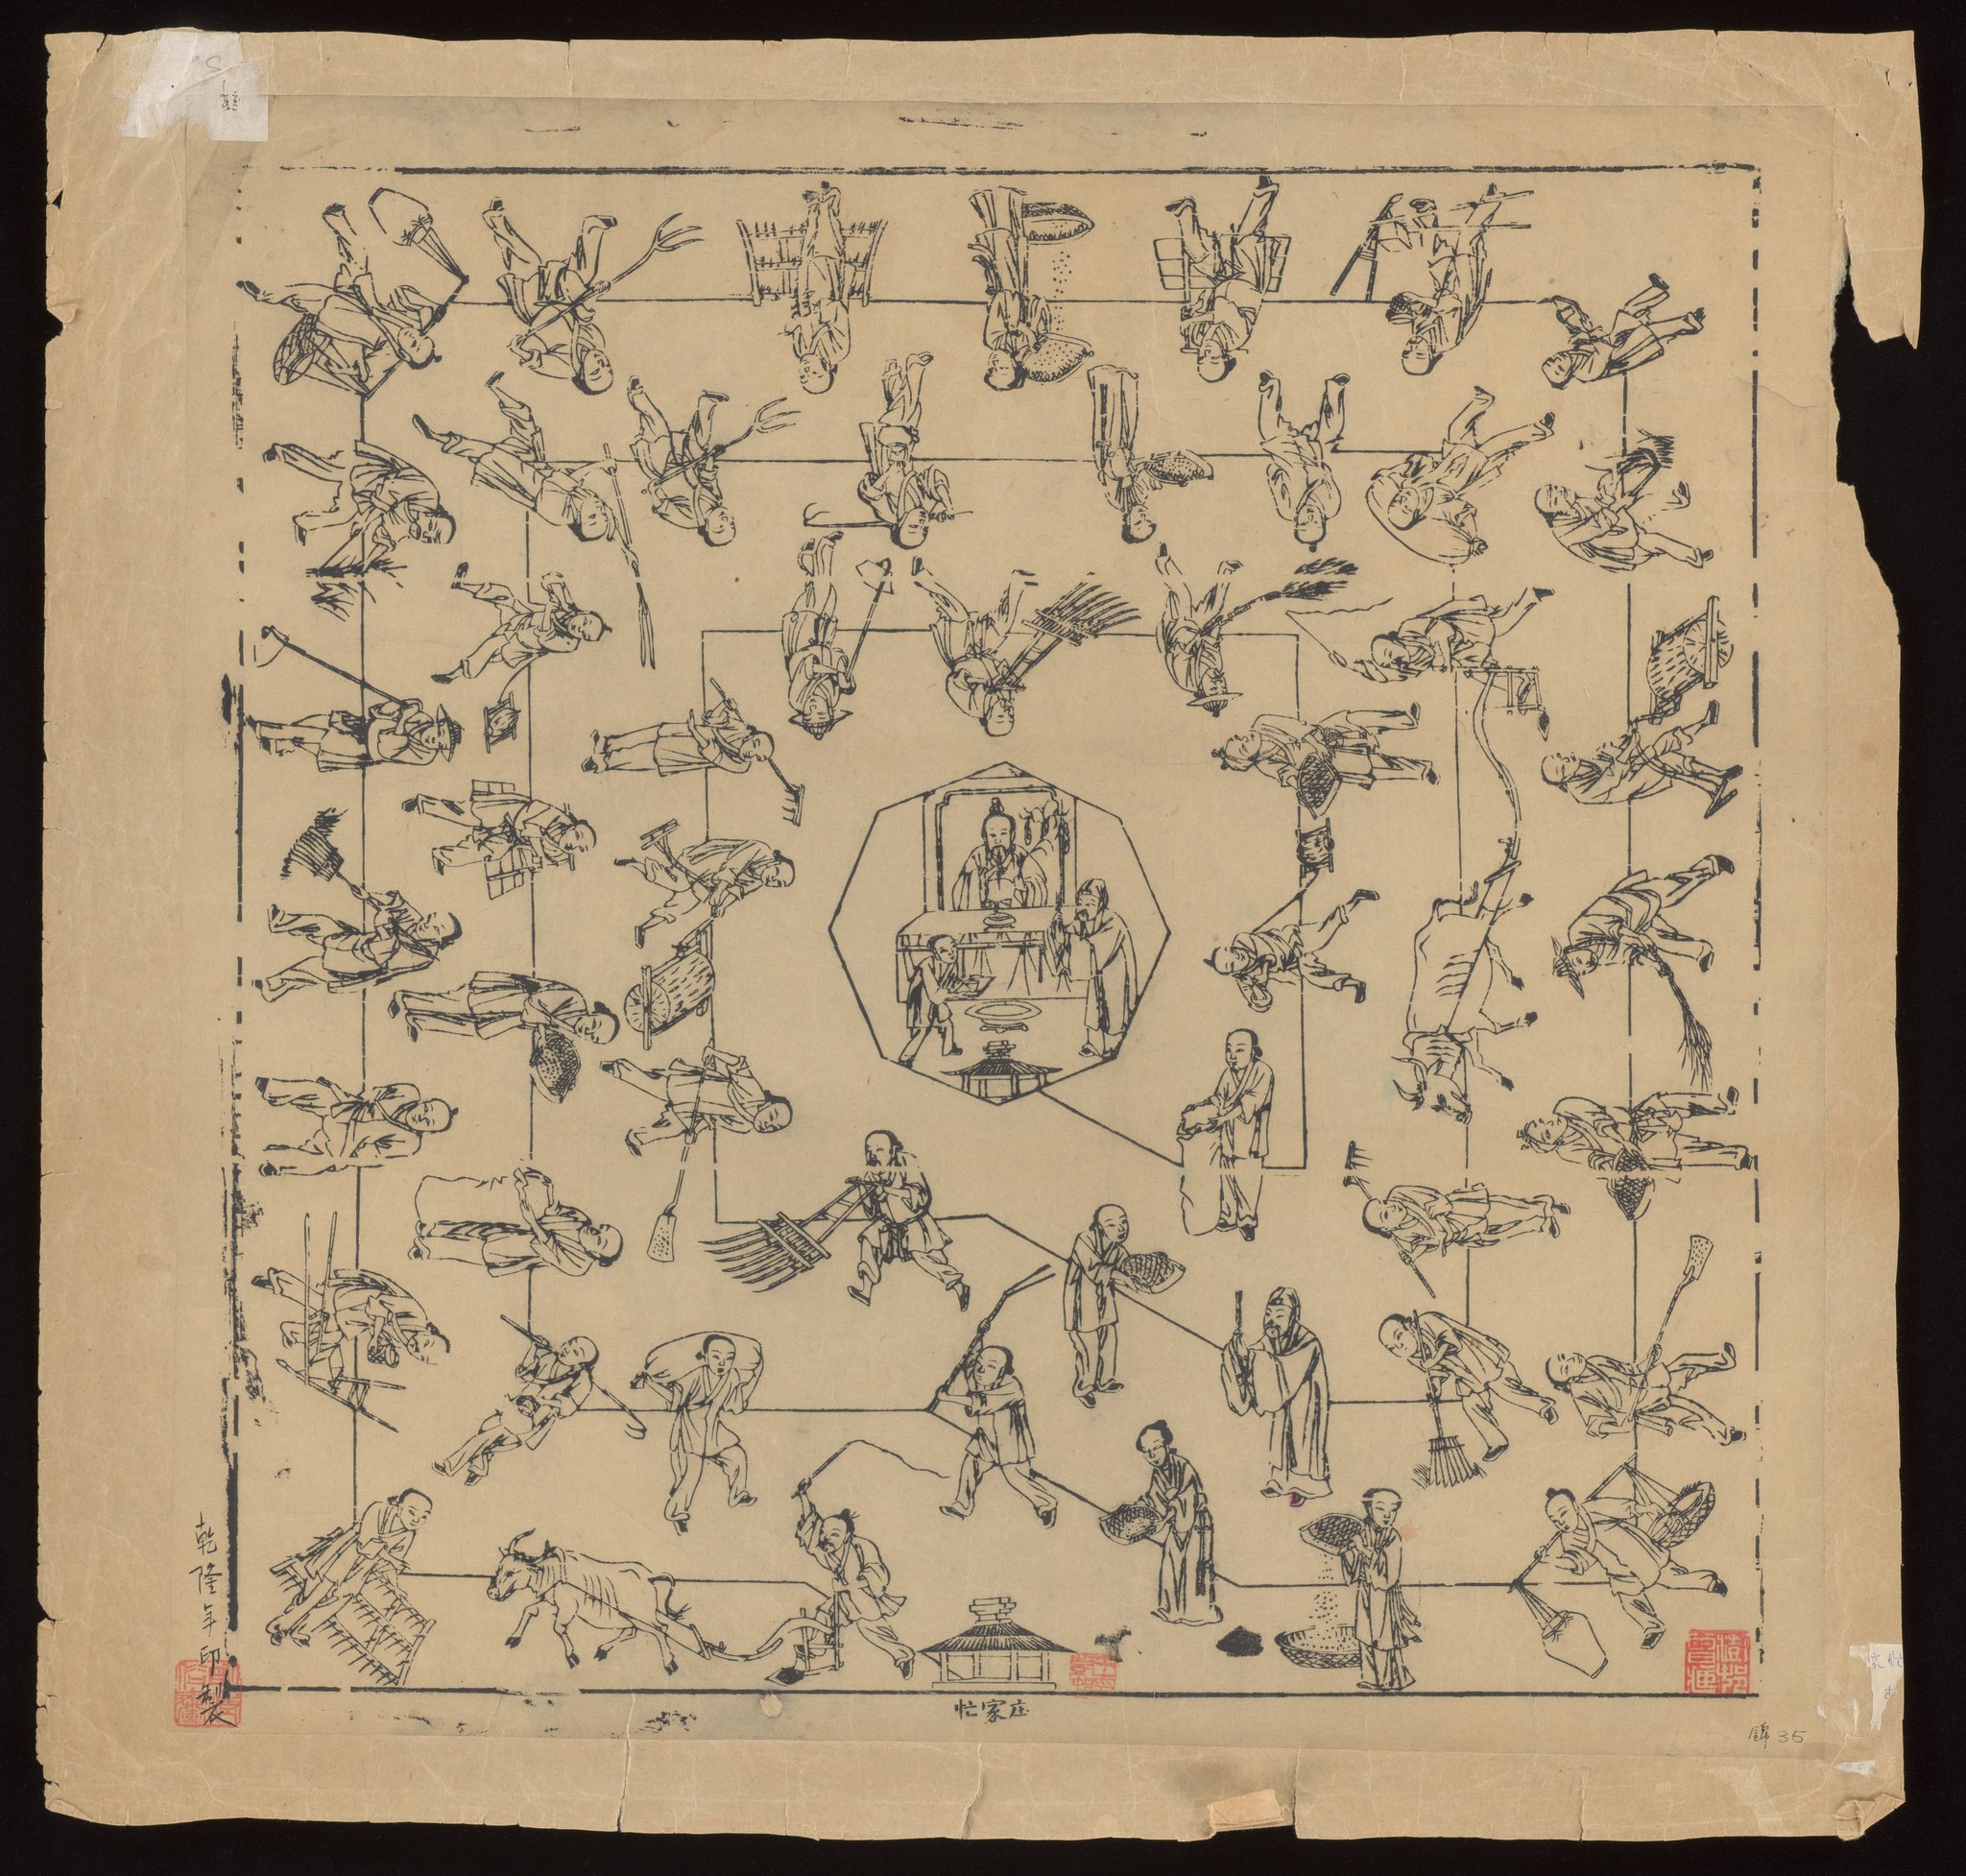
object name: print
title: Agricultural Tasks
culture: chinese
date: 1701-1800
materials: ink, paper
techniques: woodblock print